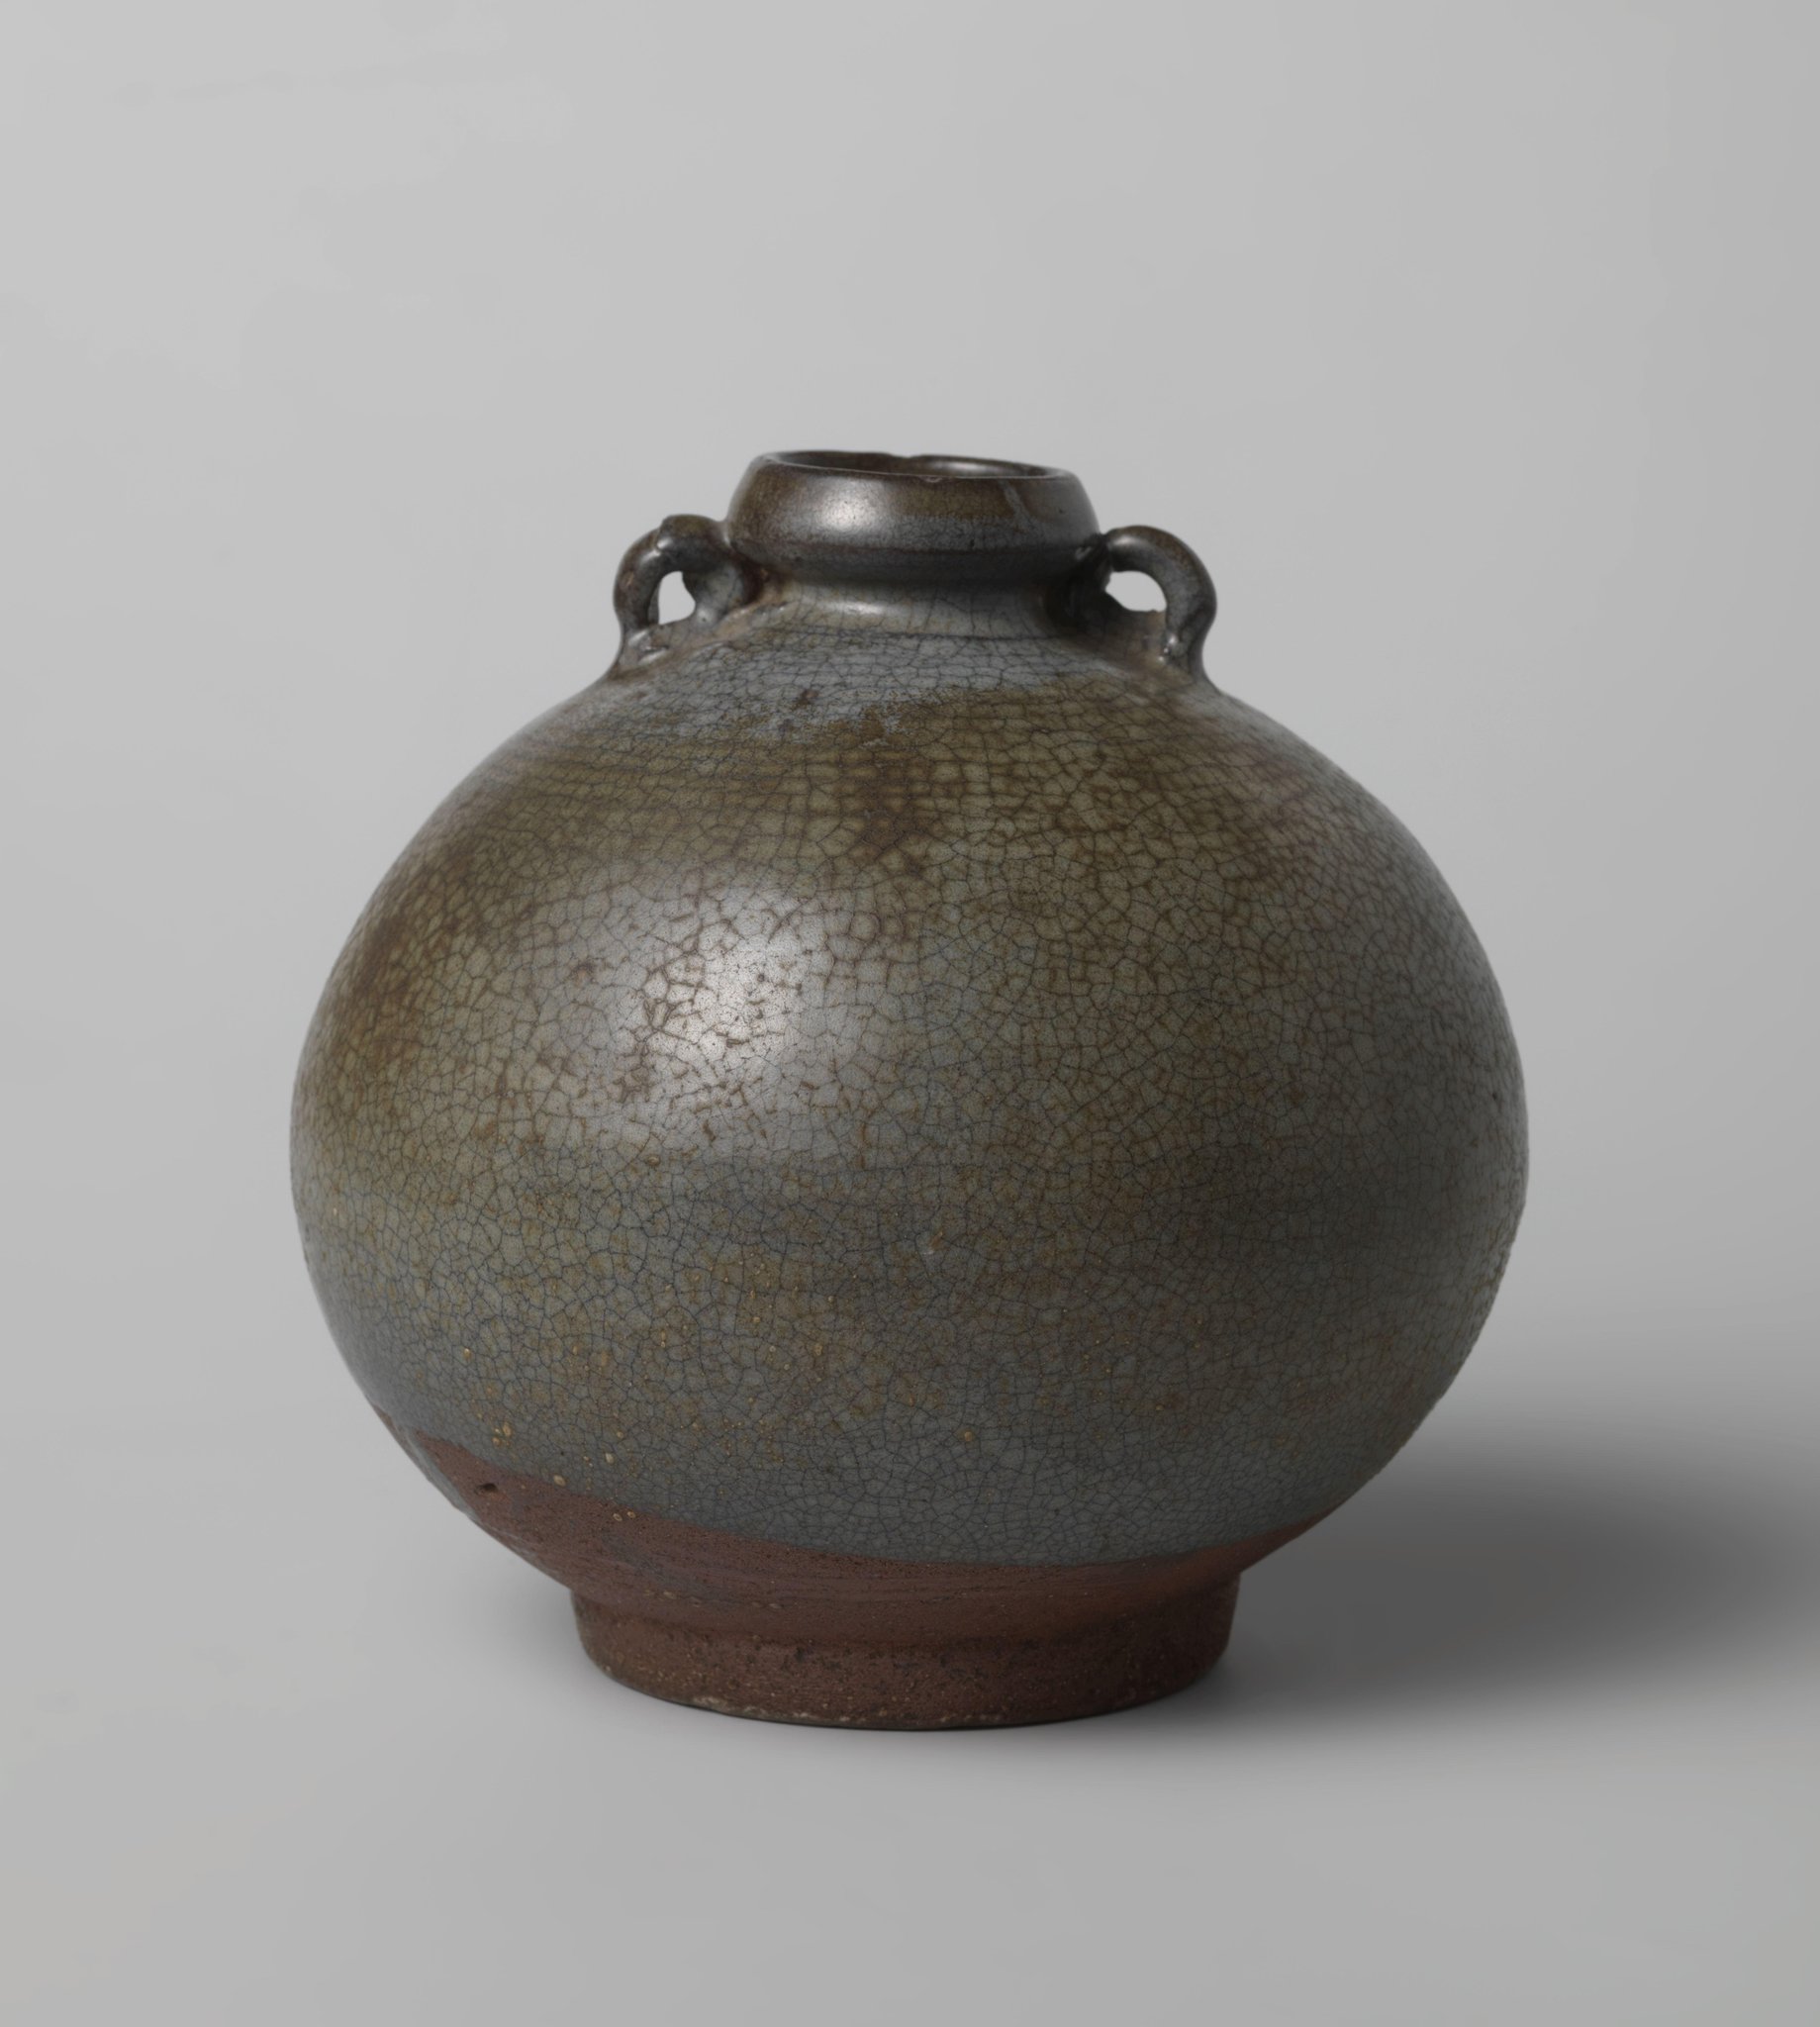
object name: pot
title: Round-bodied jar with greyish green glaze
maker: Anonymous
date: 1200-1399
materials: glaze, stoneware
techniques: firing, turning, vitrification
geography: sawankhalok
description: Bolvormige pot van steengoed met een smalle, korte nek met opstaande rand, bedekt met een grijsgroen gecraqueleerd glazuur. Vanuit de schouder twee halfronde oren. Celadon.